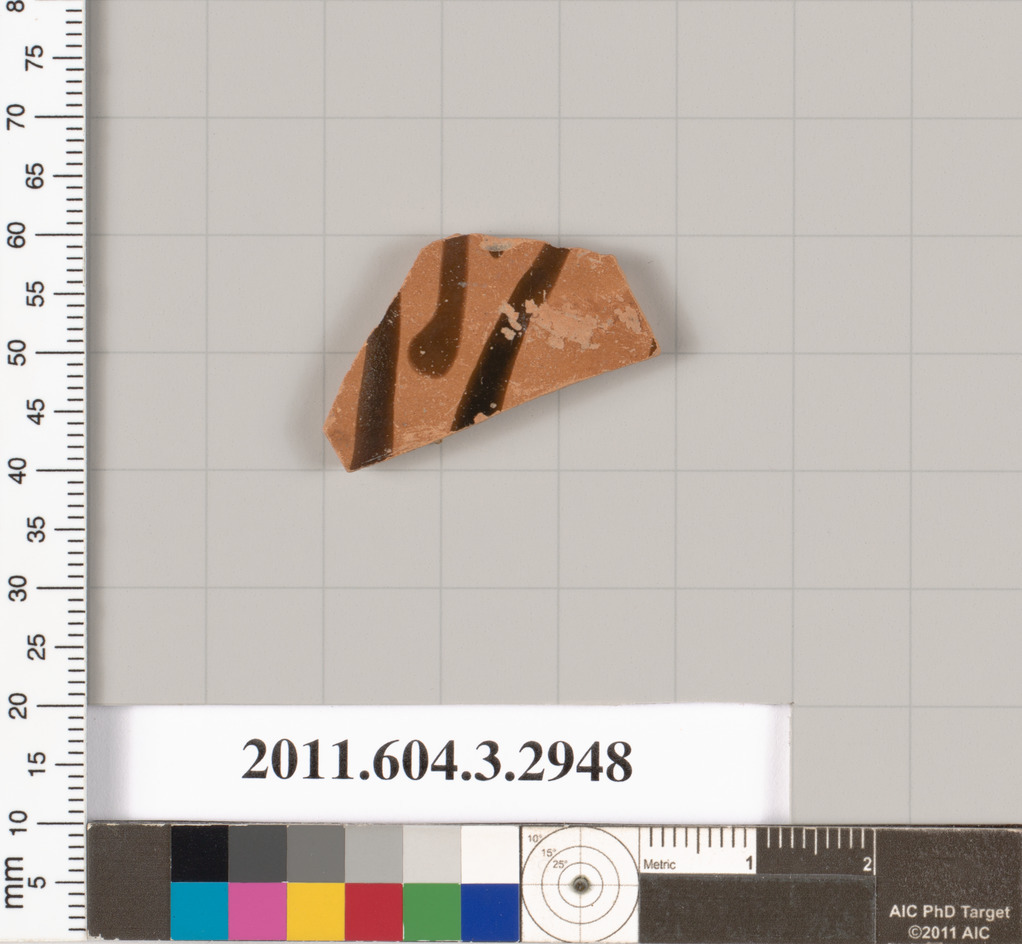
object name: undetermined closed shape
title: Terracotta fragment of a closed shape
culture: greek, attic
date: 534-468 BCE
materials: terracotta